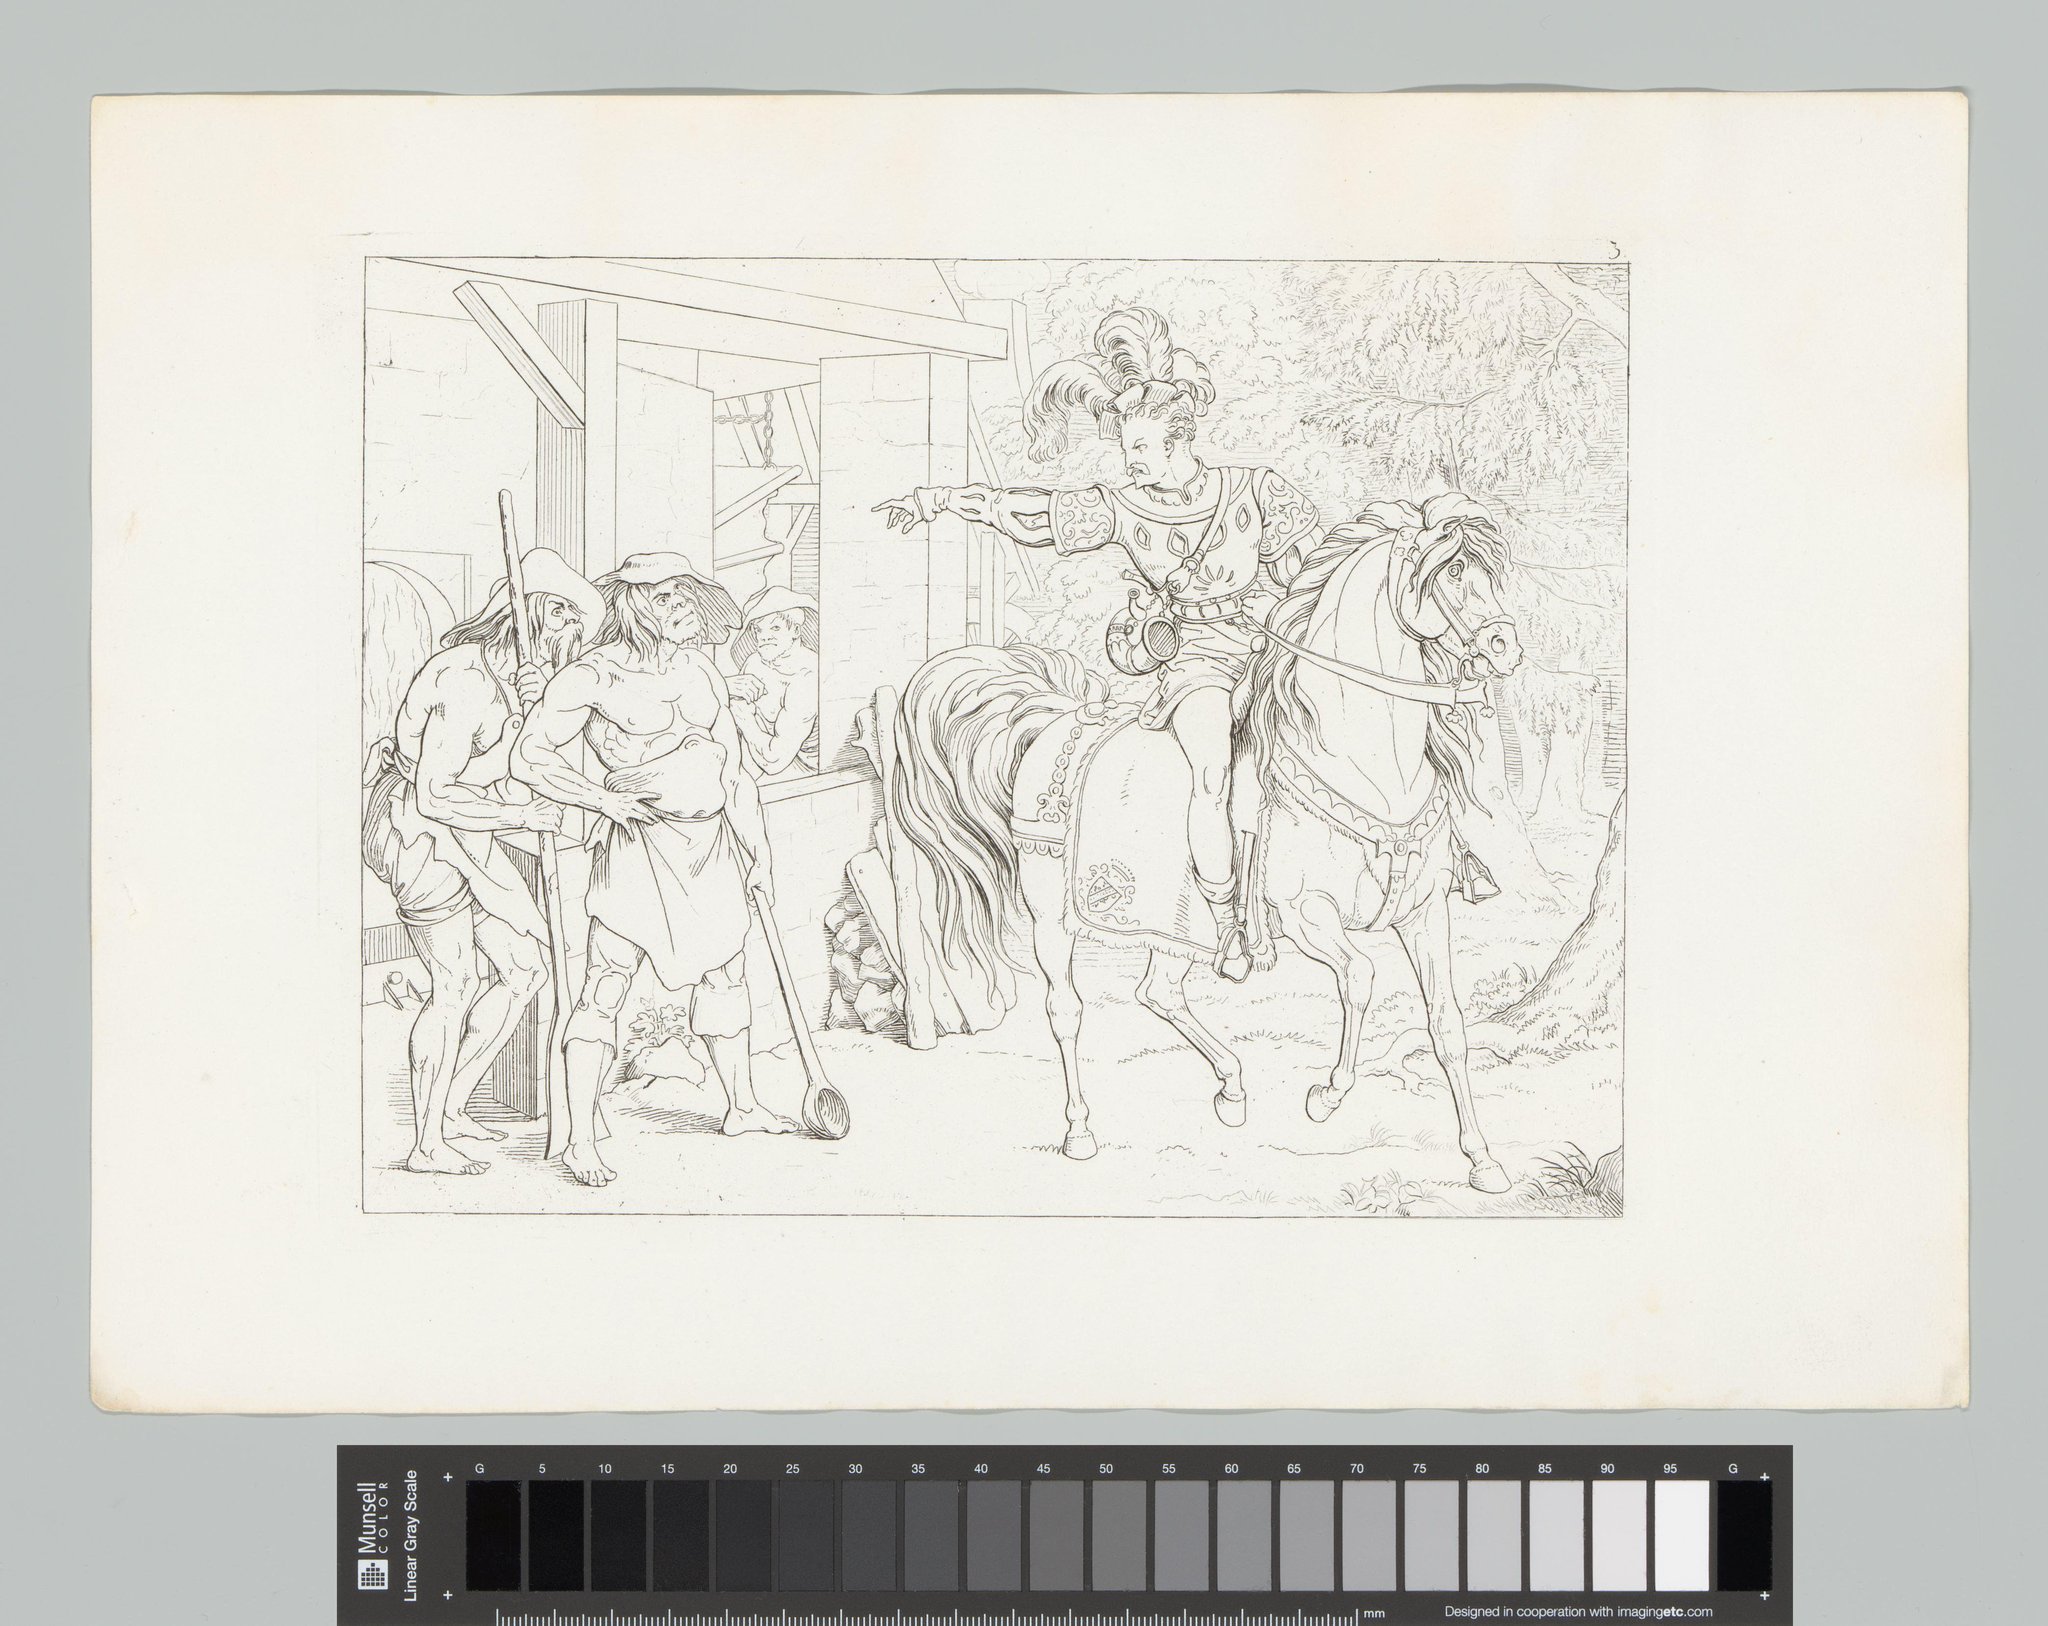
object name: print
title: Edelman bij een smid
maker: moritz retzsch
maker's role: print maker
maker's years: 1779-1857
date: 1823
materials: paper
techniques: etching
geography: stuttgart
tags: smith, blacksmith, nobility and patriciate; chivalry, knighthood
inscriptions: date